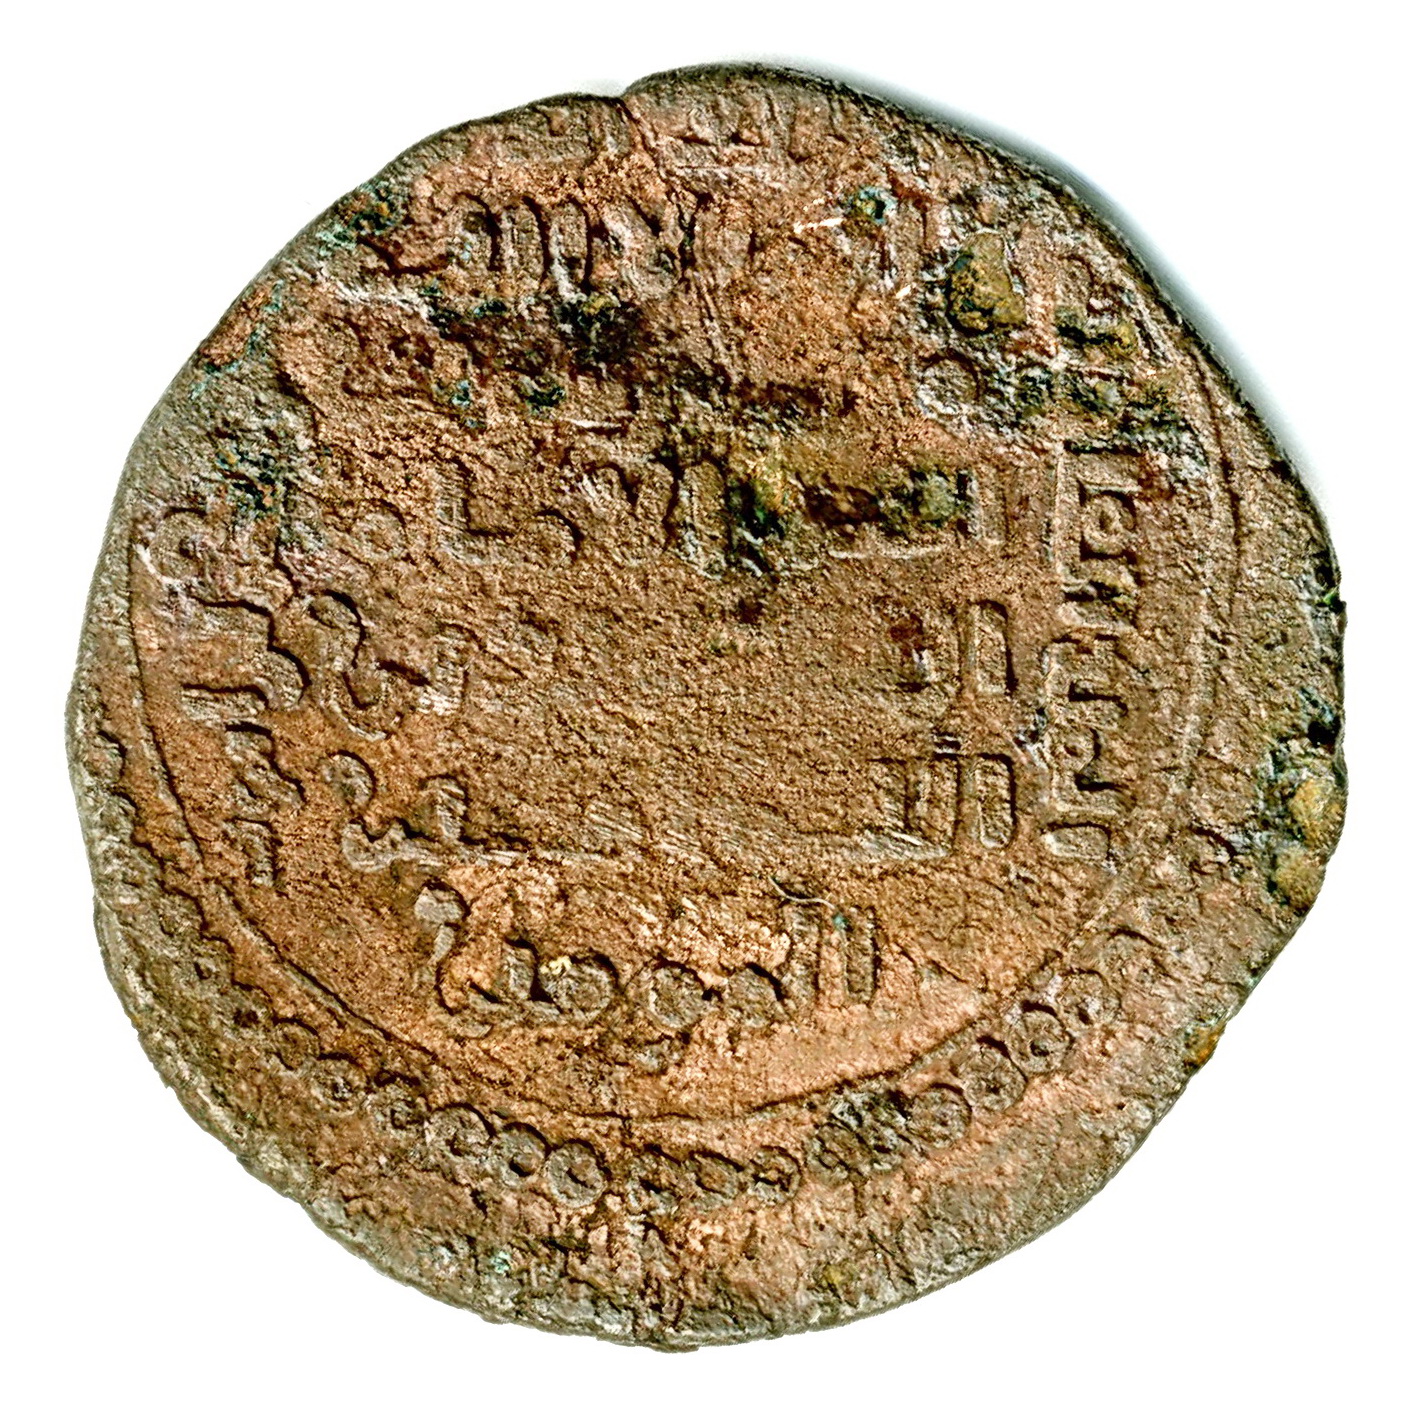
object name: coin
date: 1169-1260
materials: copper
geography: iran